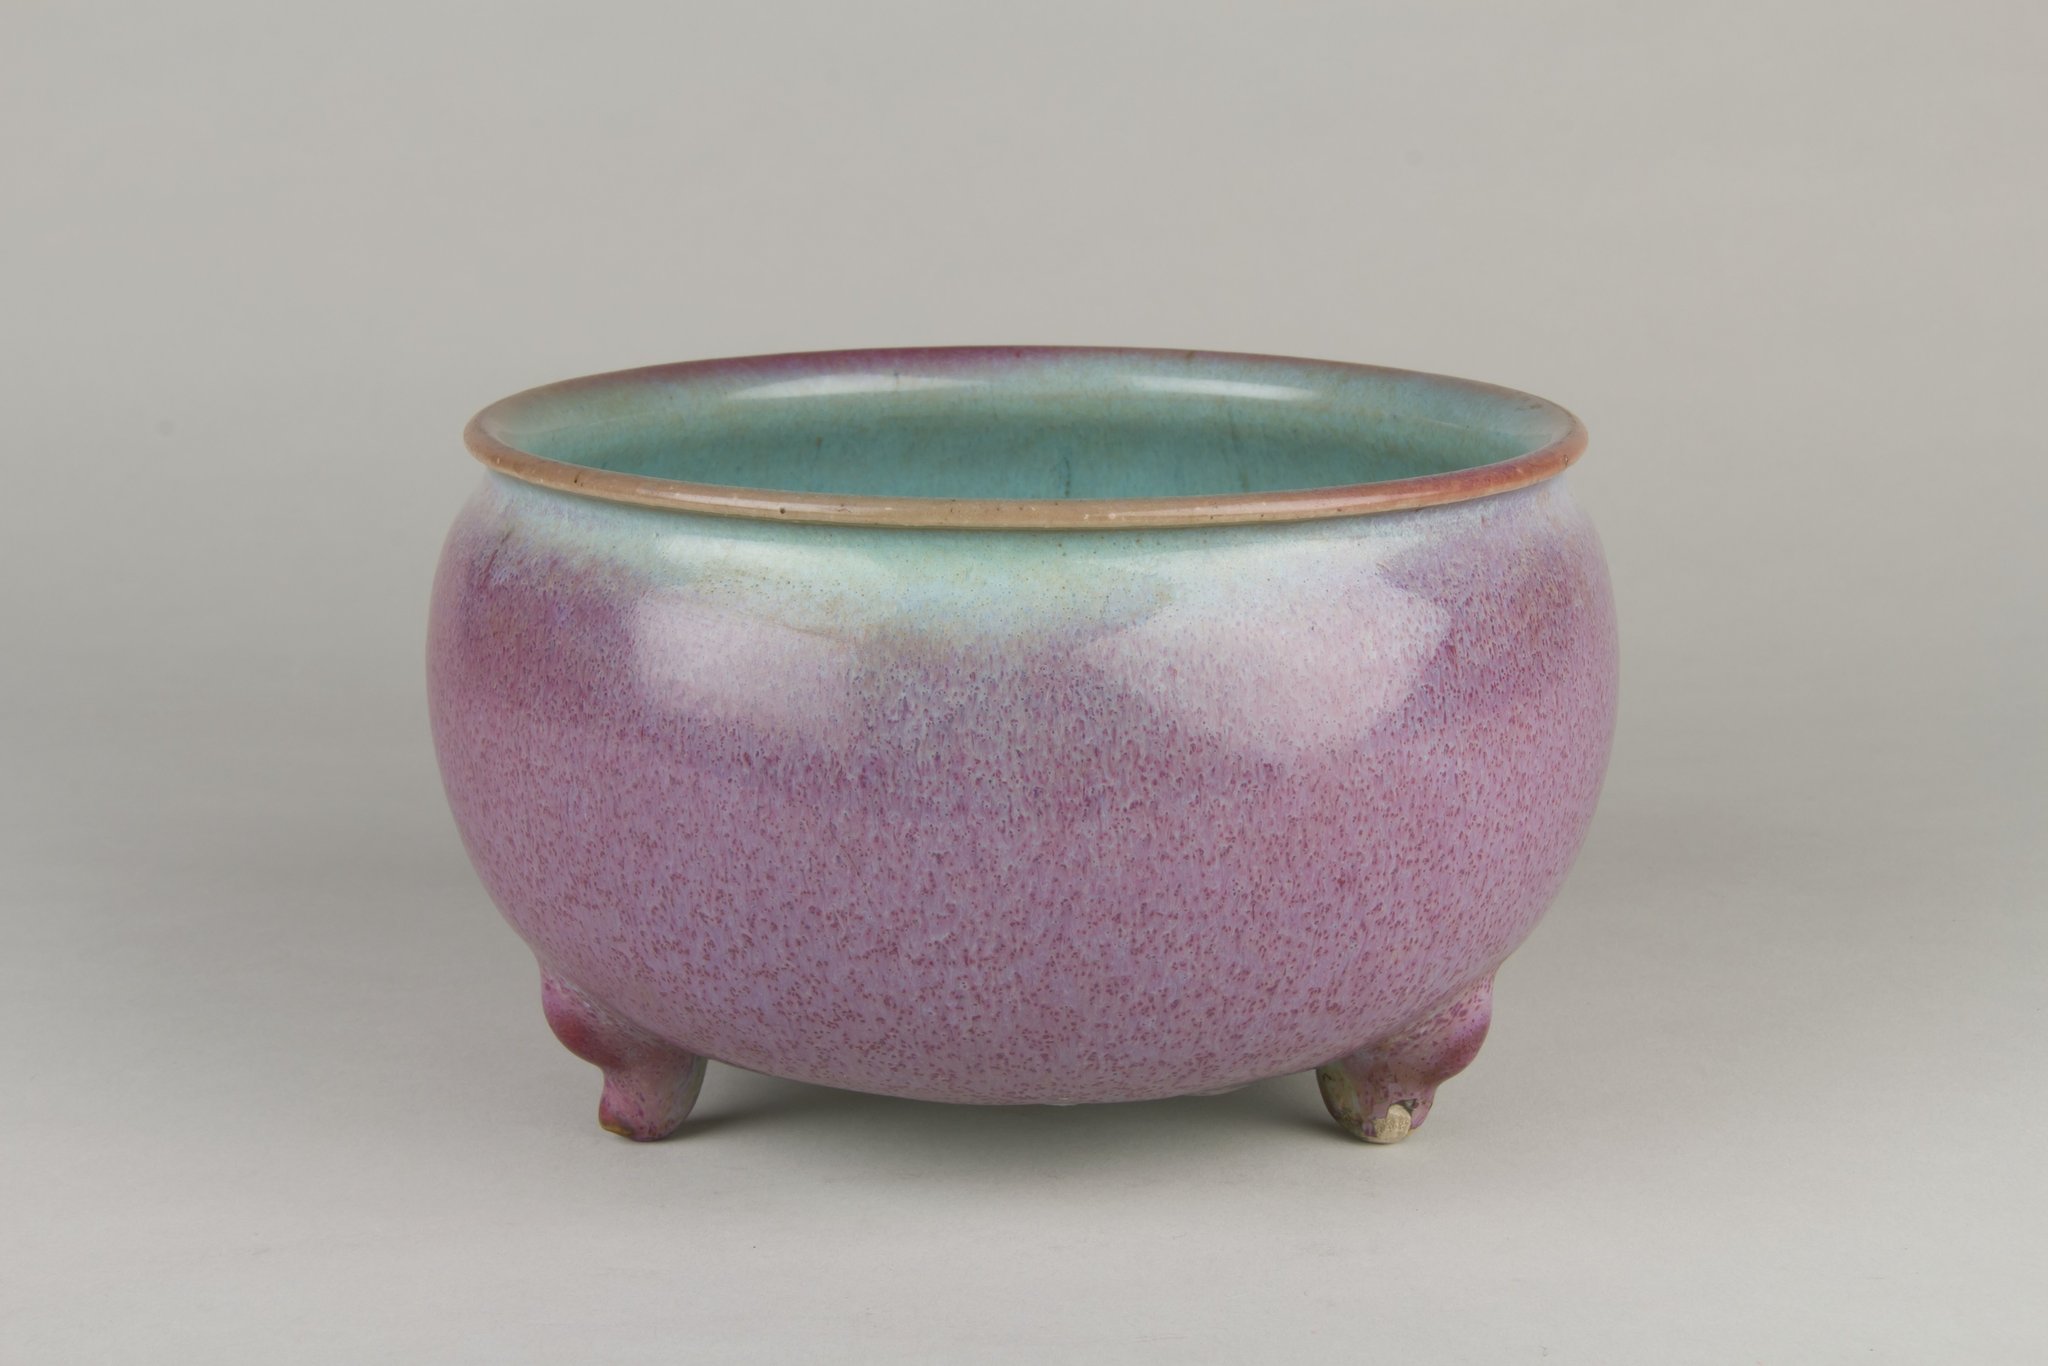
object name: incense burner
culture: chinese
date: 960-1279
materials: pottery